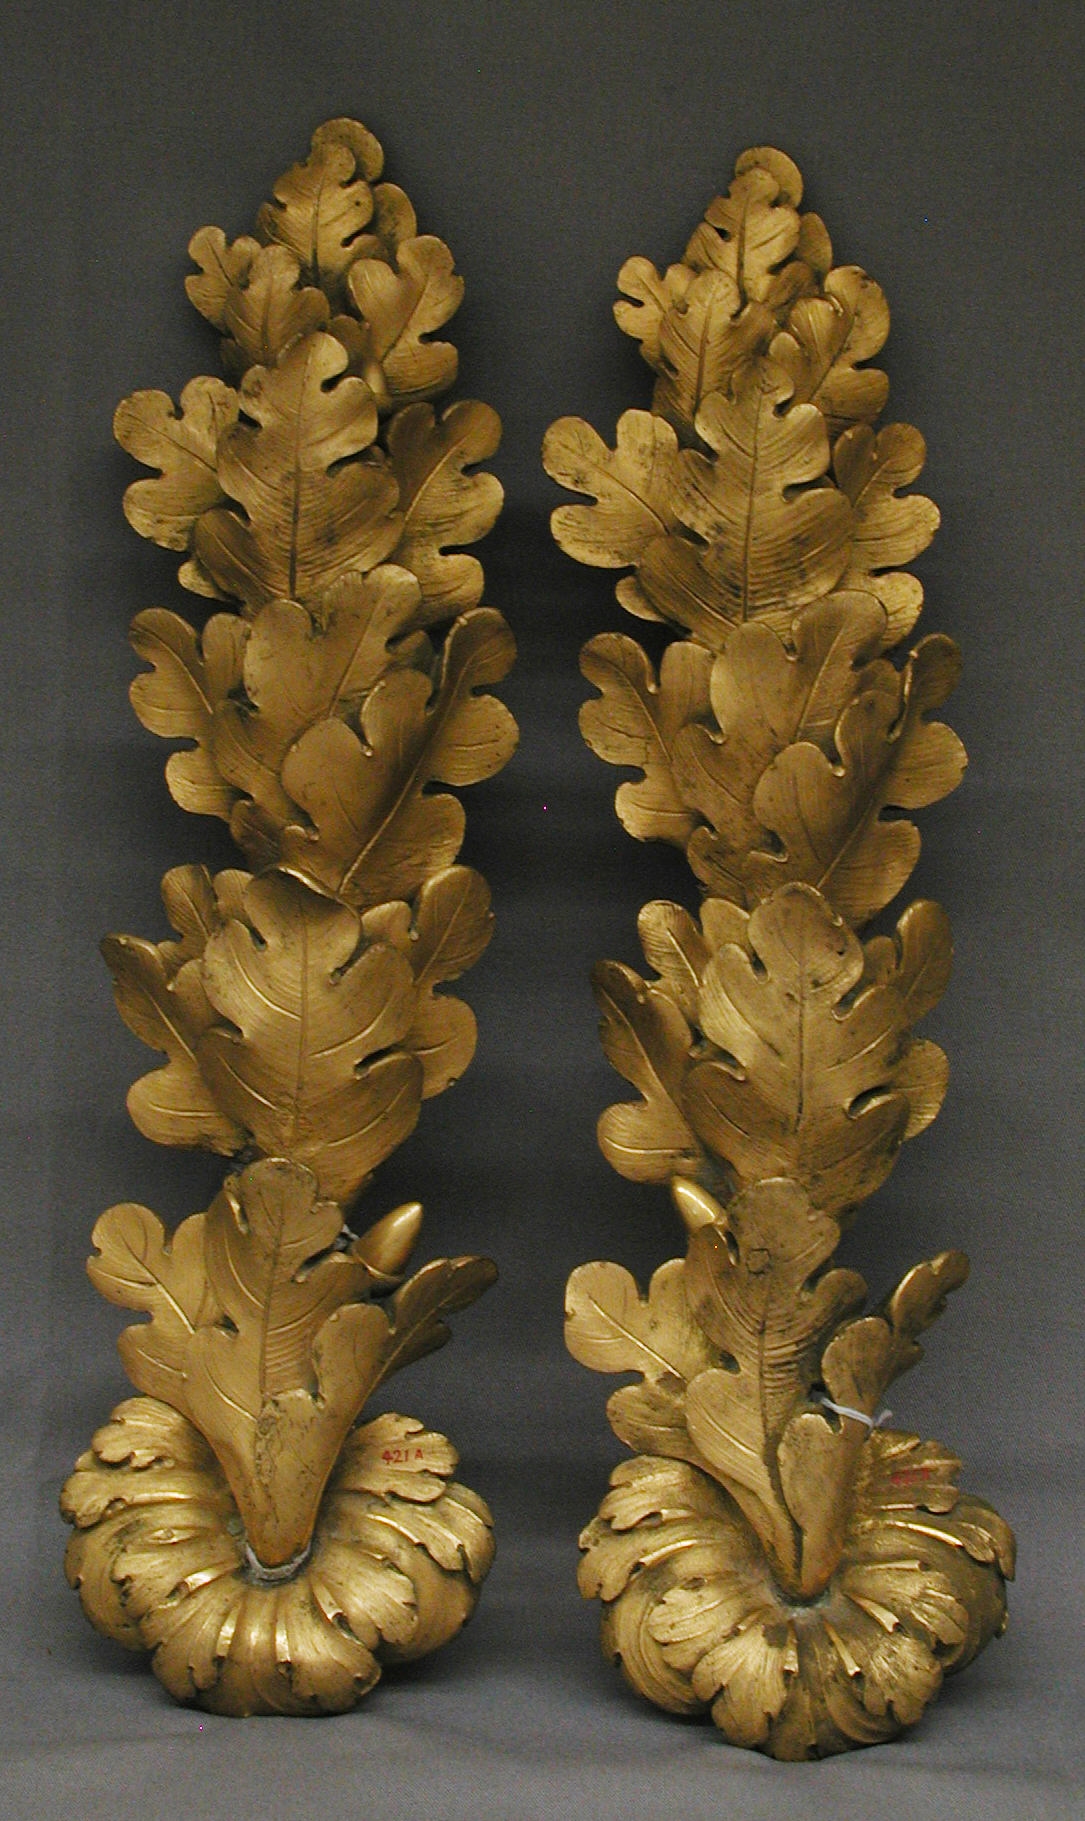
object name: chute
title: Pair of chutes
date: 1701-1800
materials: gilt bronze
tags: leaves